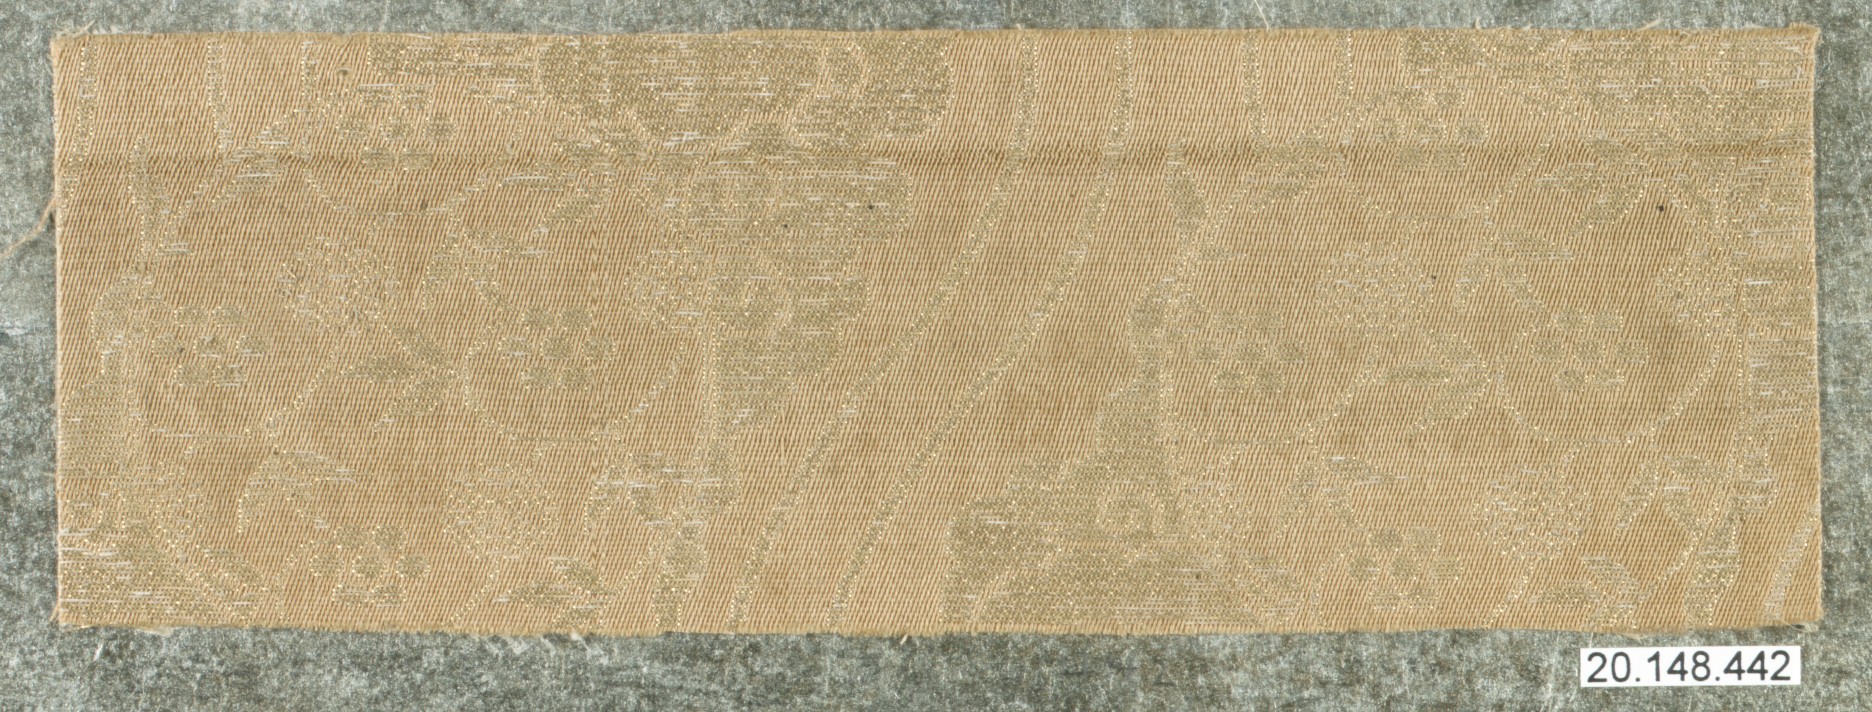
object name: piece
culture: japanese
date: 1601-1700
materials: silk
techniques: compound weave